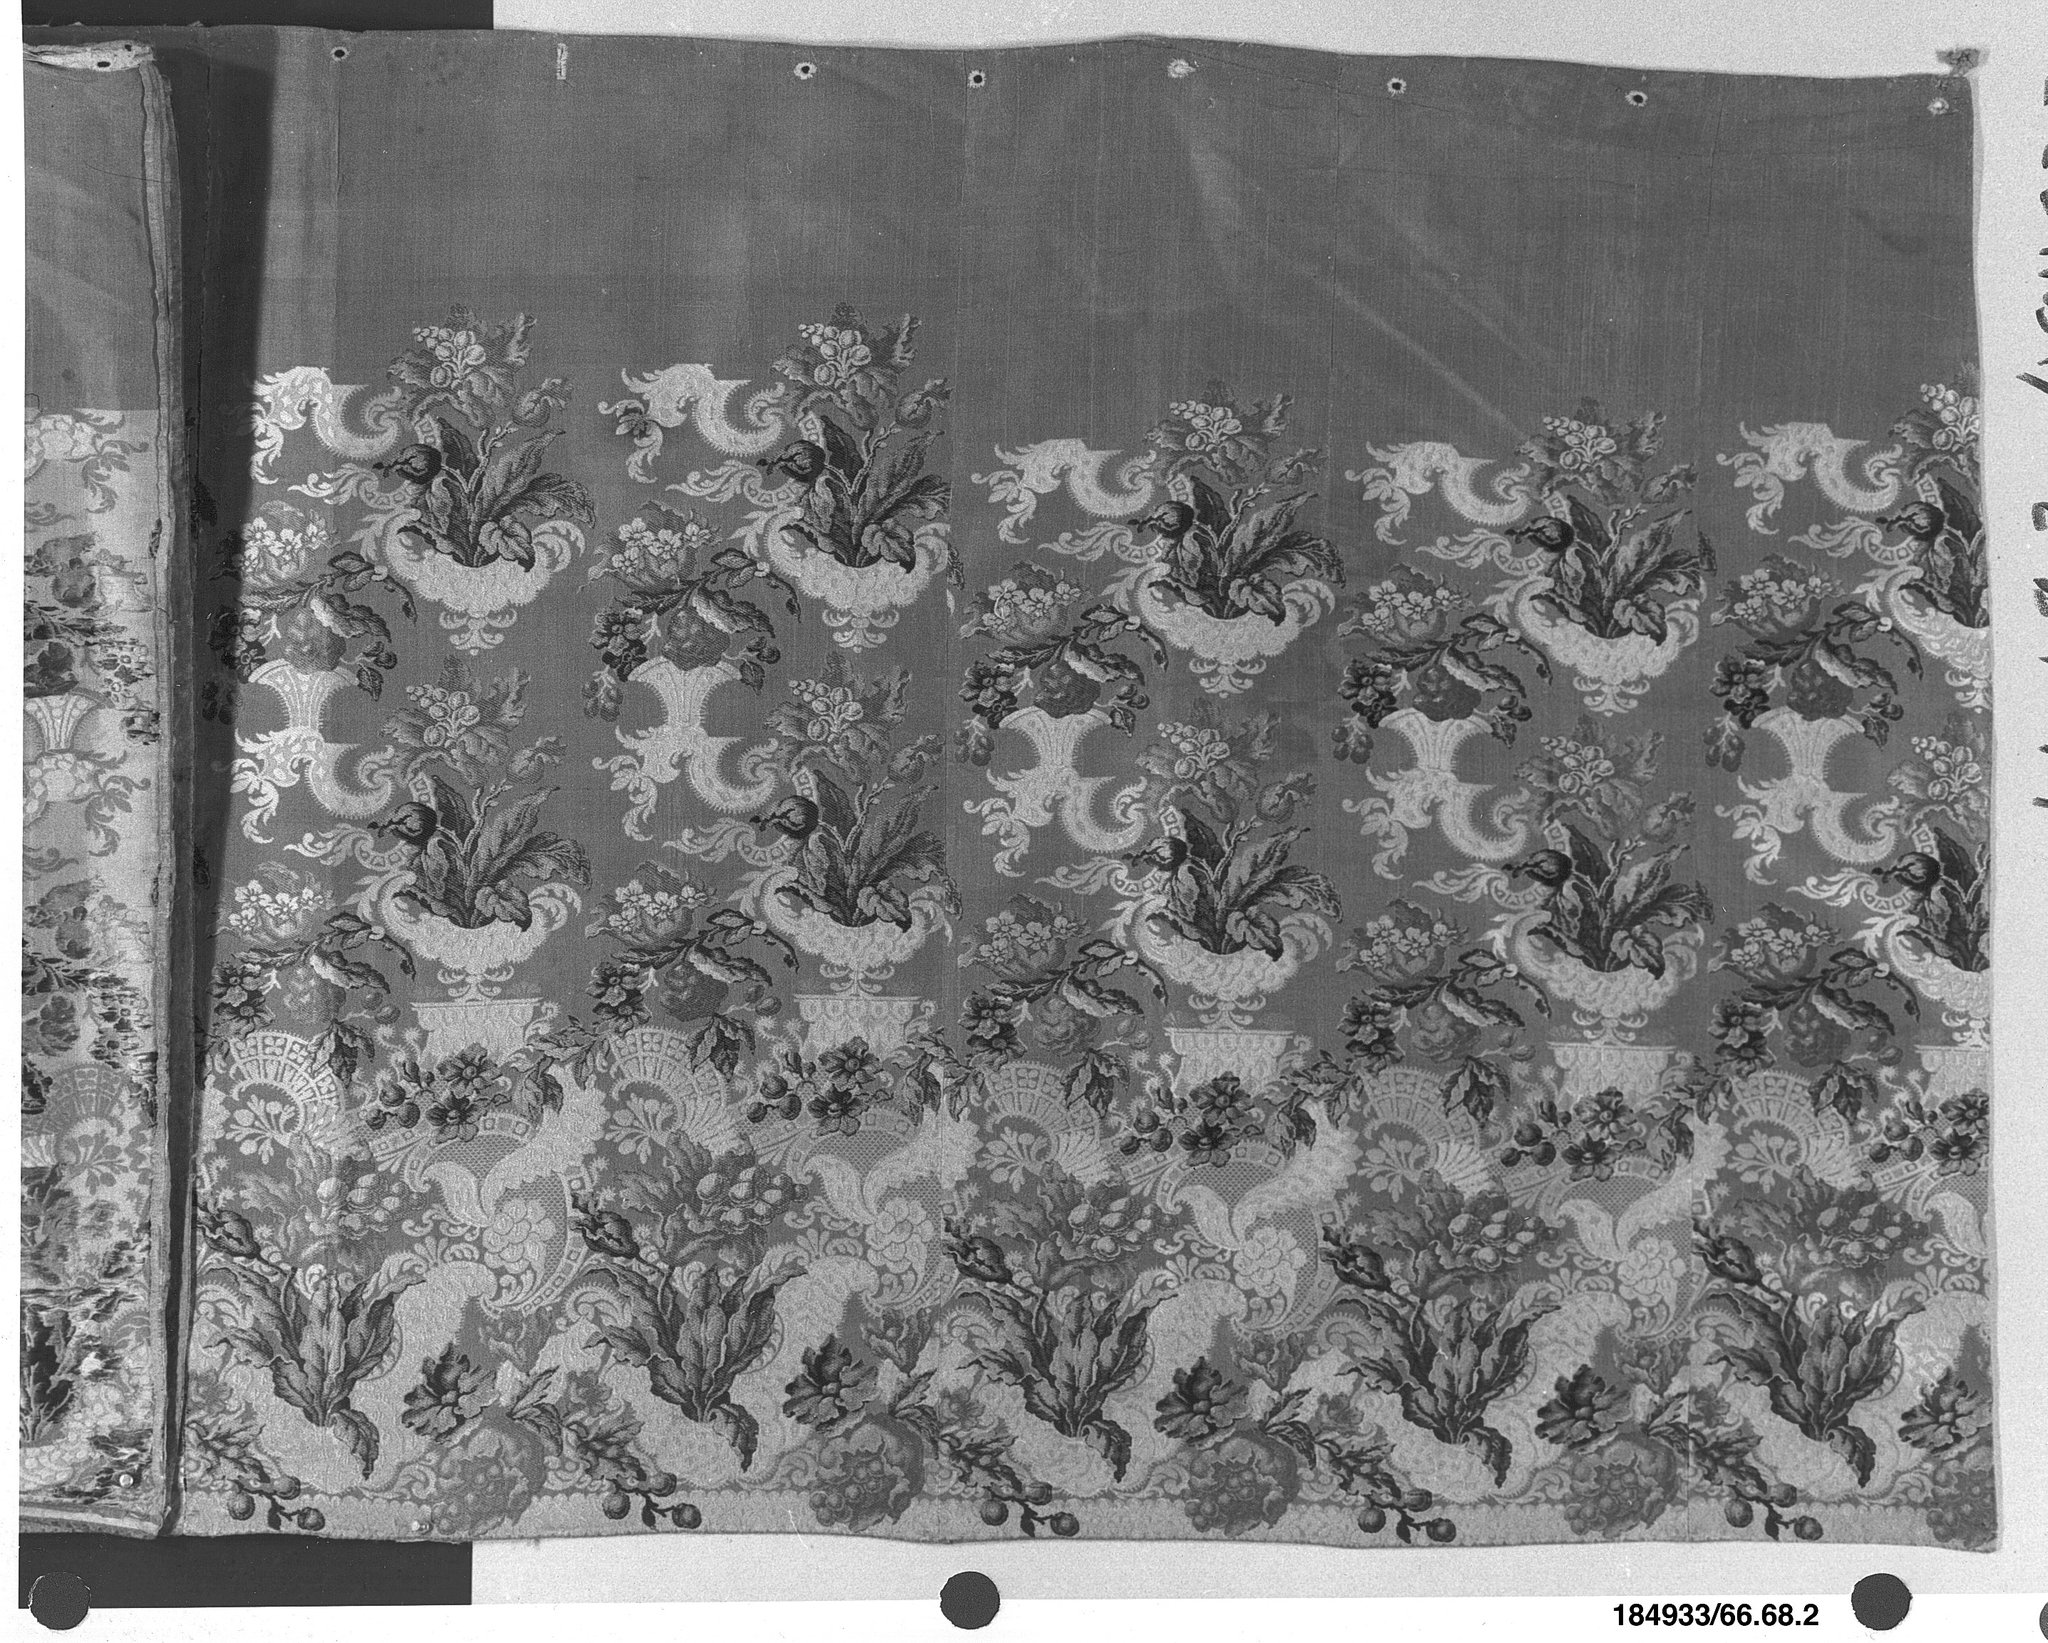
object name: skirt panel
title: Panel from a skirt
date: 1745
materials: silk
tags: flowers,leaves